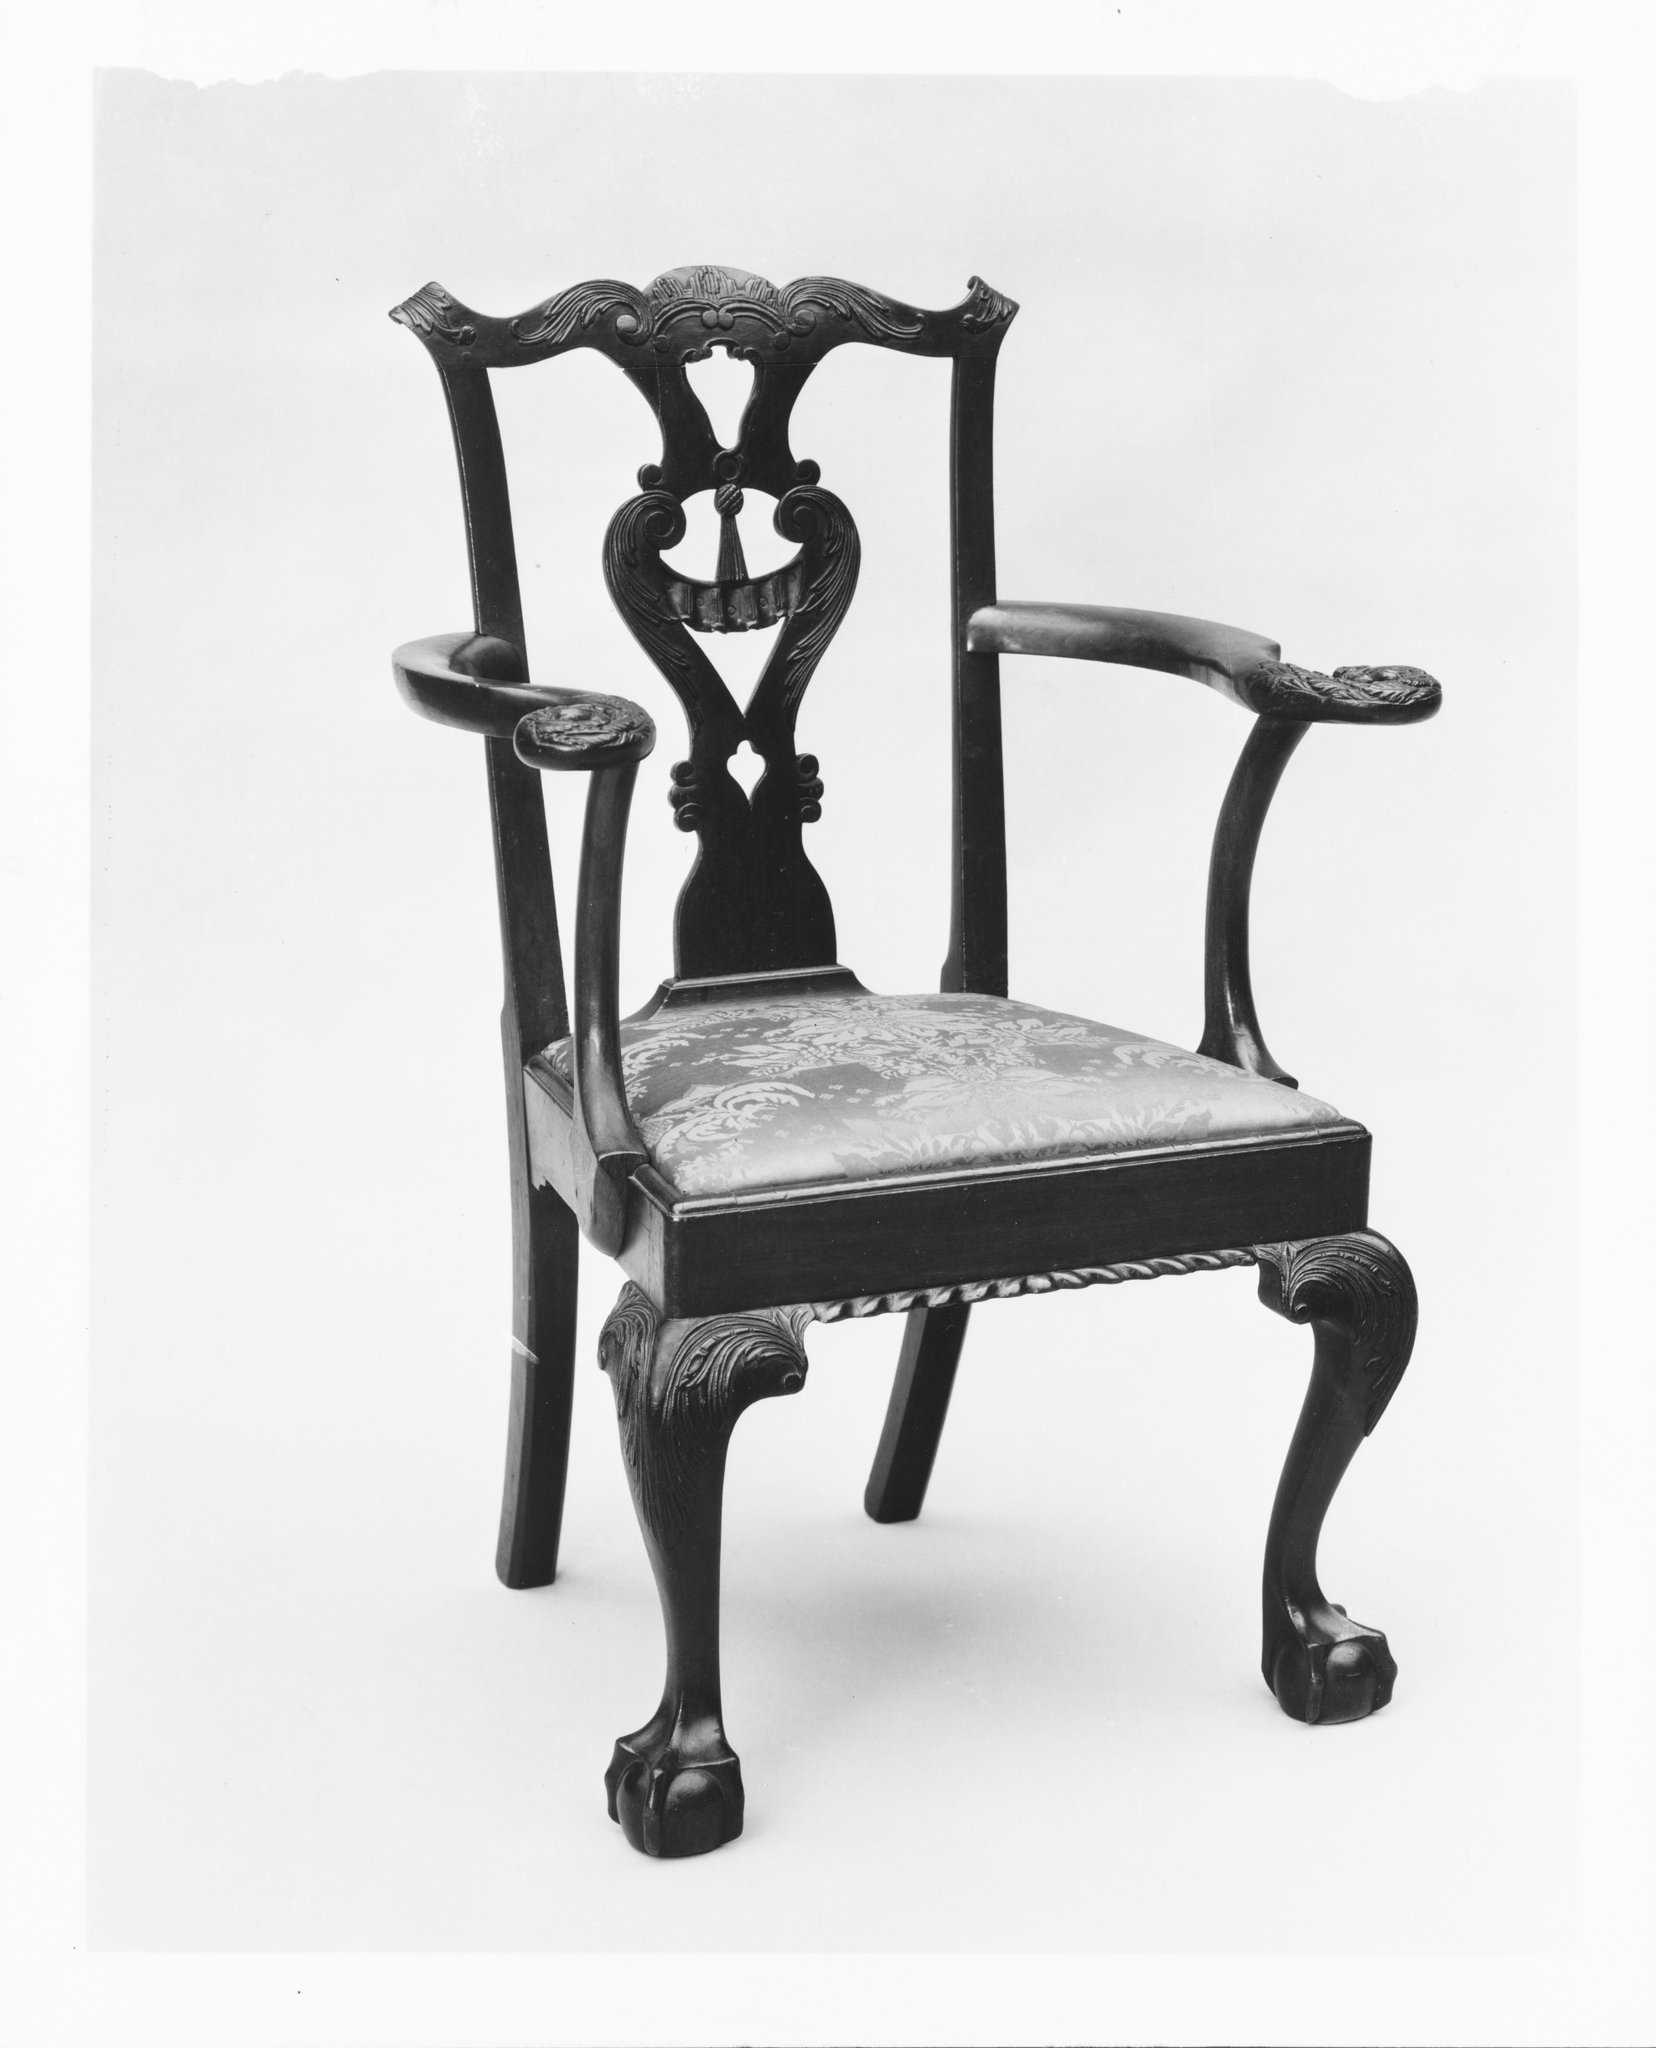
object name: armchair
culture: american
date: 1755-1775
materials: wood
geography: united states